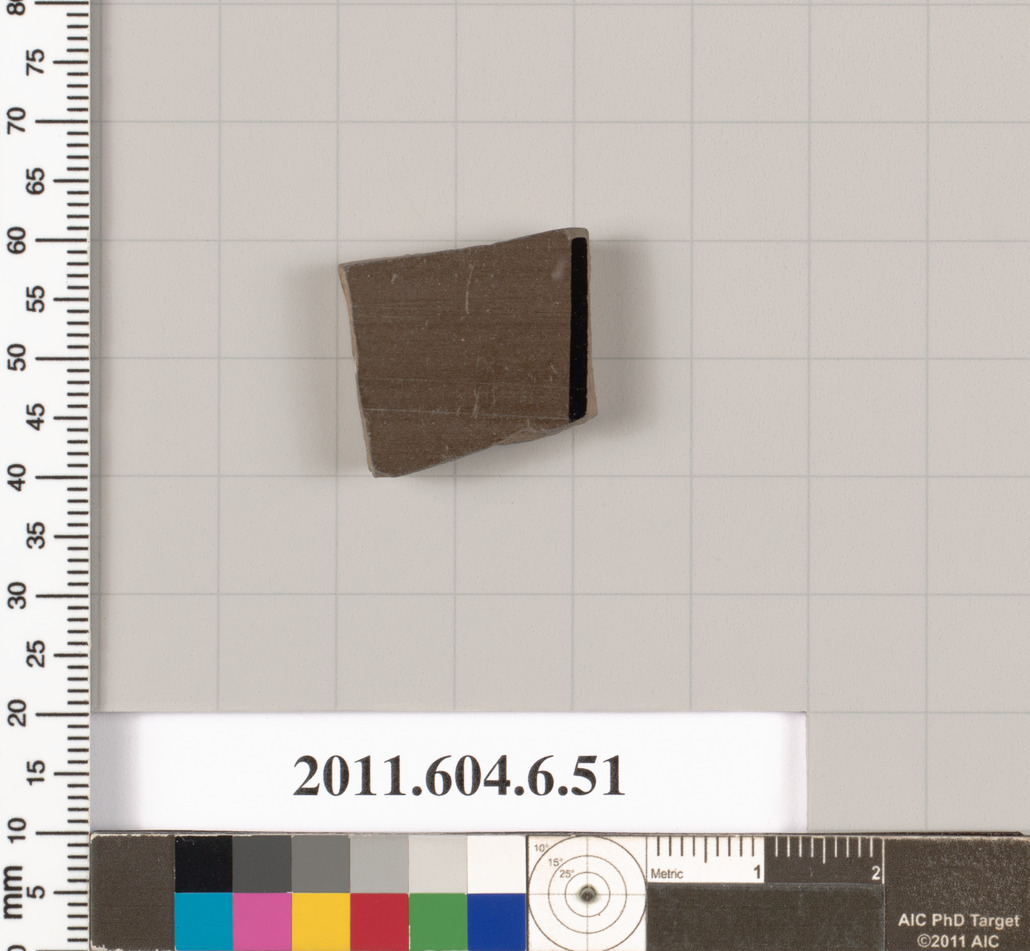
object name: undetermined closed shape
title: Terracotta fragment of a closed shape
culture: greek, attic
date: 600-401 BCE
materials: terracotta